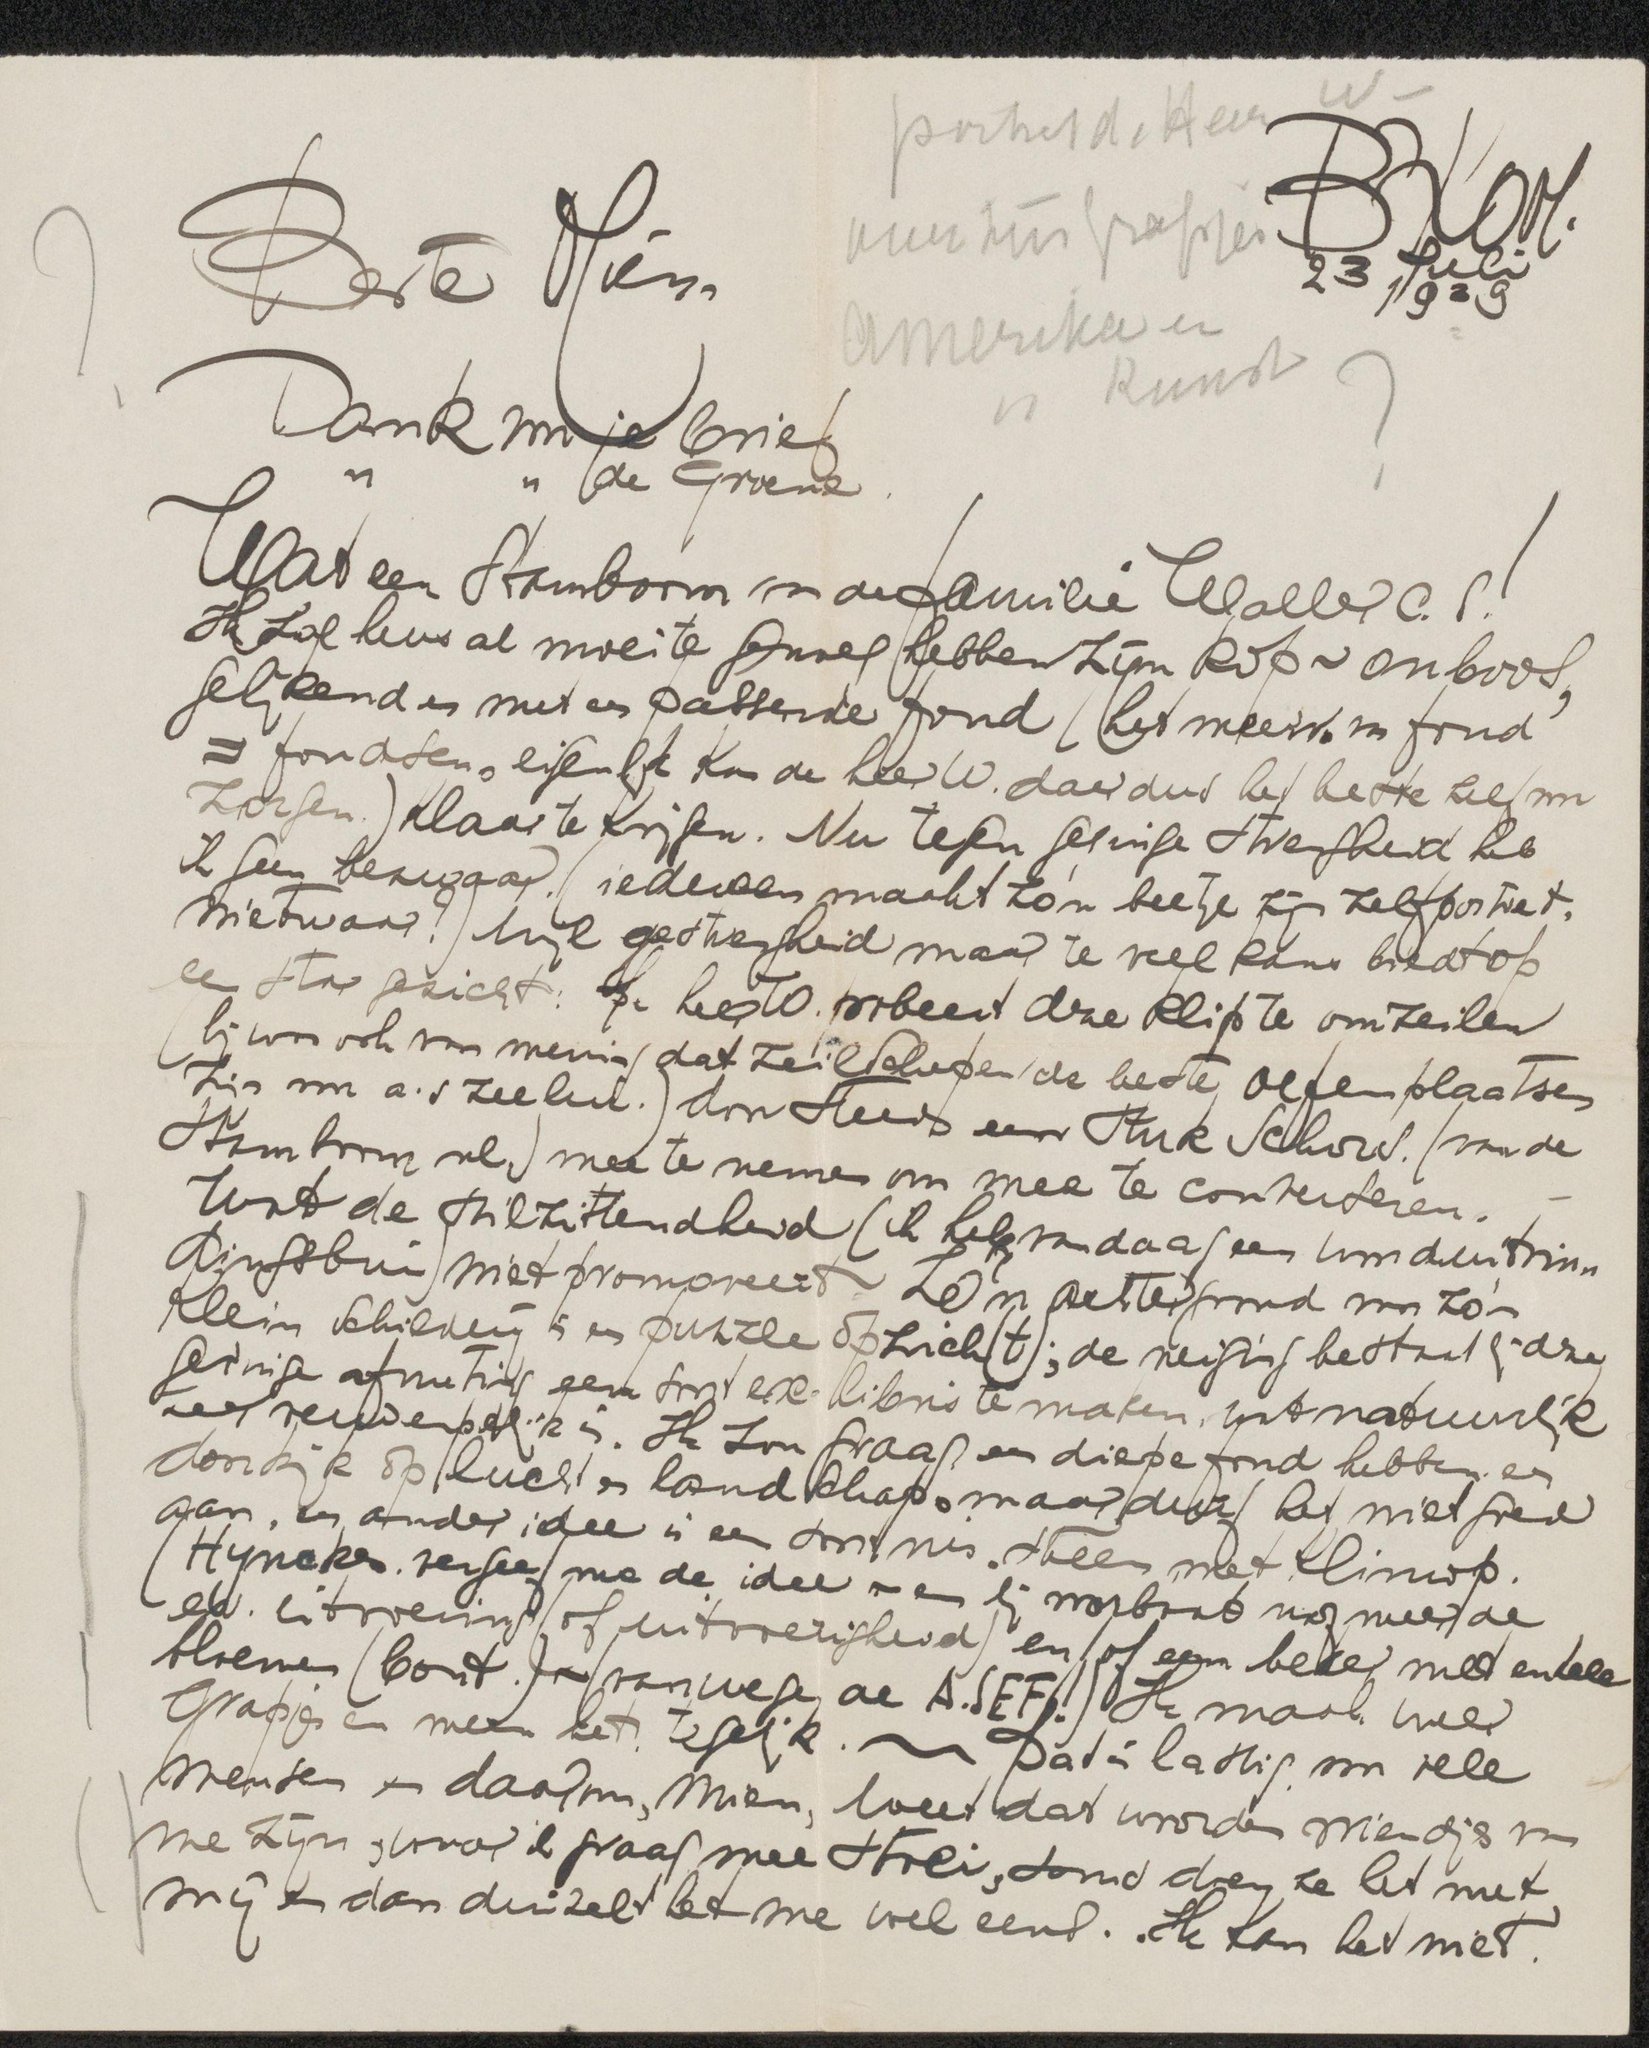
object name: letter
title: Brief aan Mien Cambier van Nooten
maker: dick ket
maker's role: draughtsman, print maker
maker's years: 1902-1940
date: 1939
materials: ink, paper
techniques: pen, writing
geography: bennekom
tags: amsterdam, arnhem, mien cambier van nooten, painting (including book-illumination, miniature-painting), historical persons (portraits and scenes from the life)